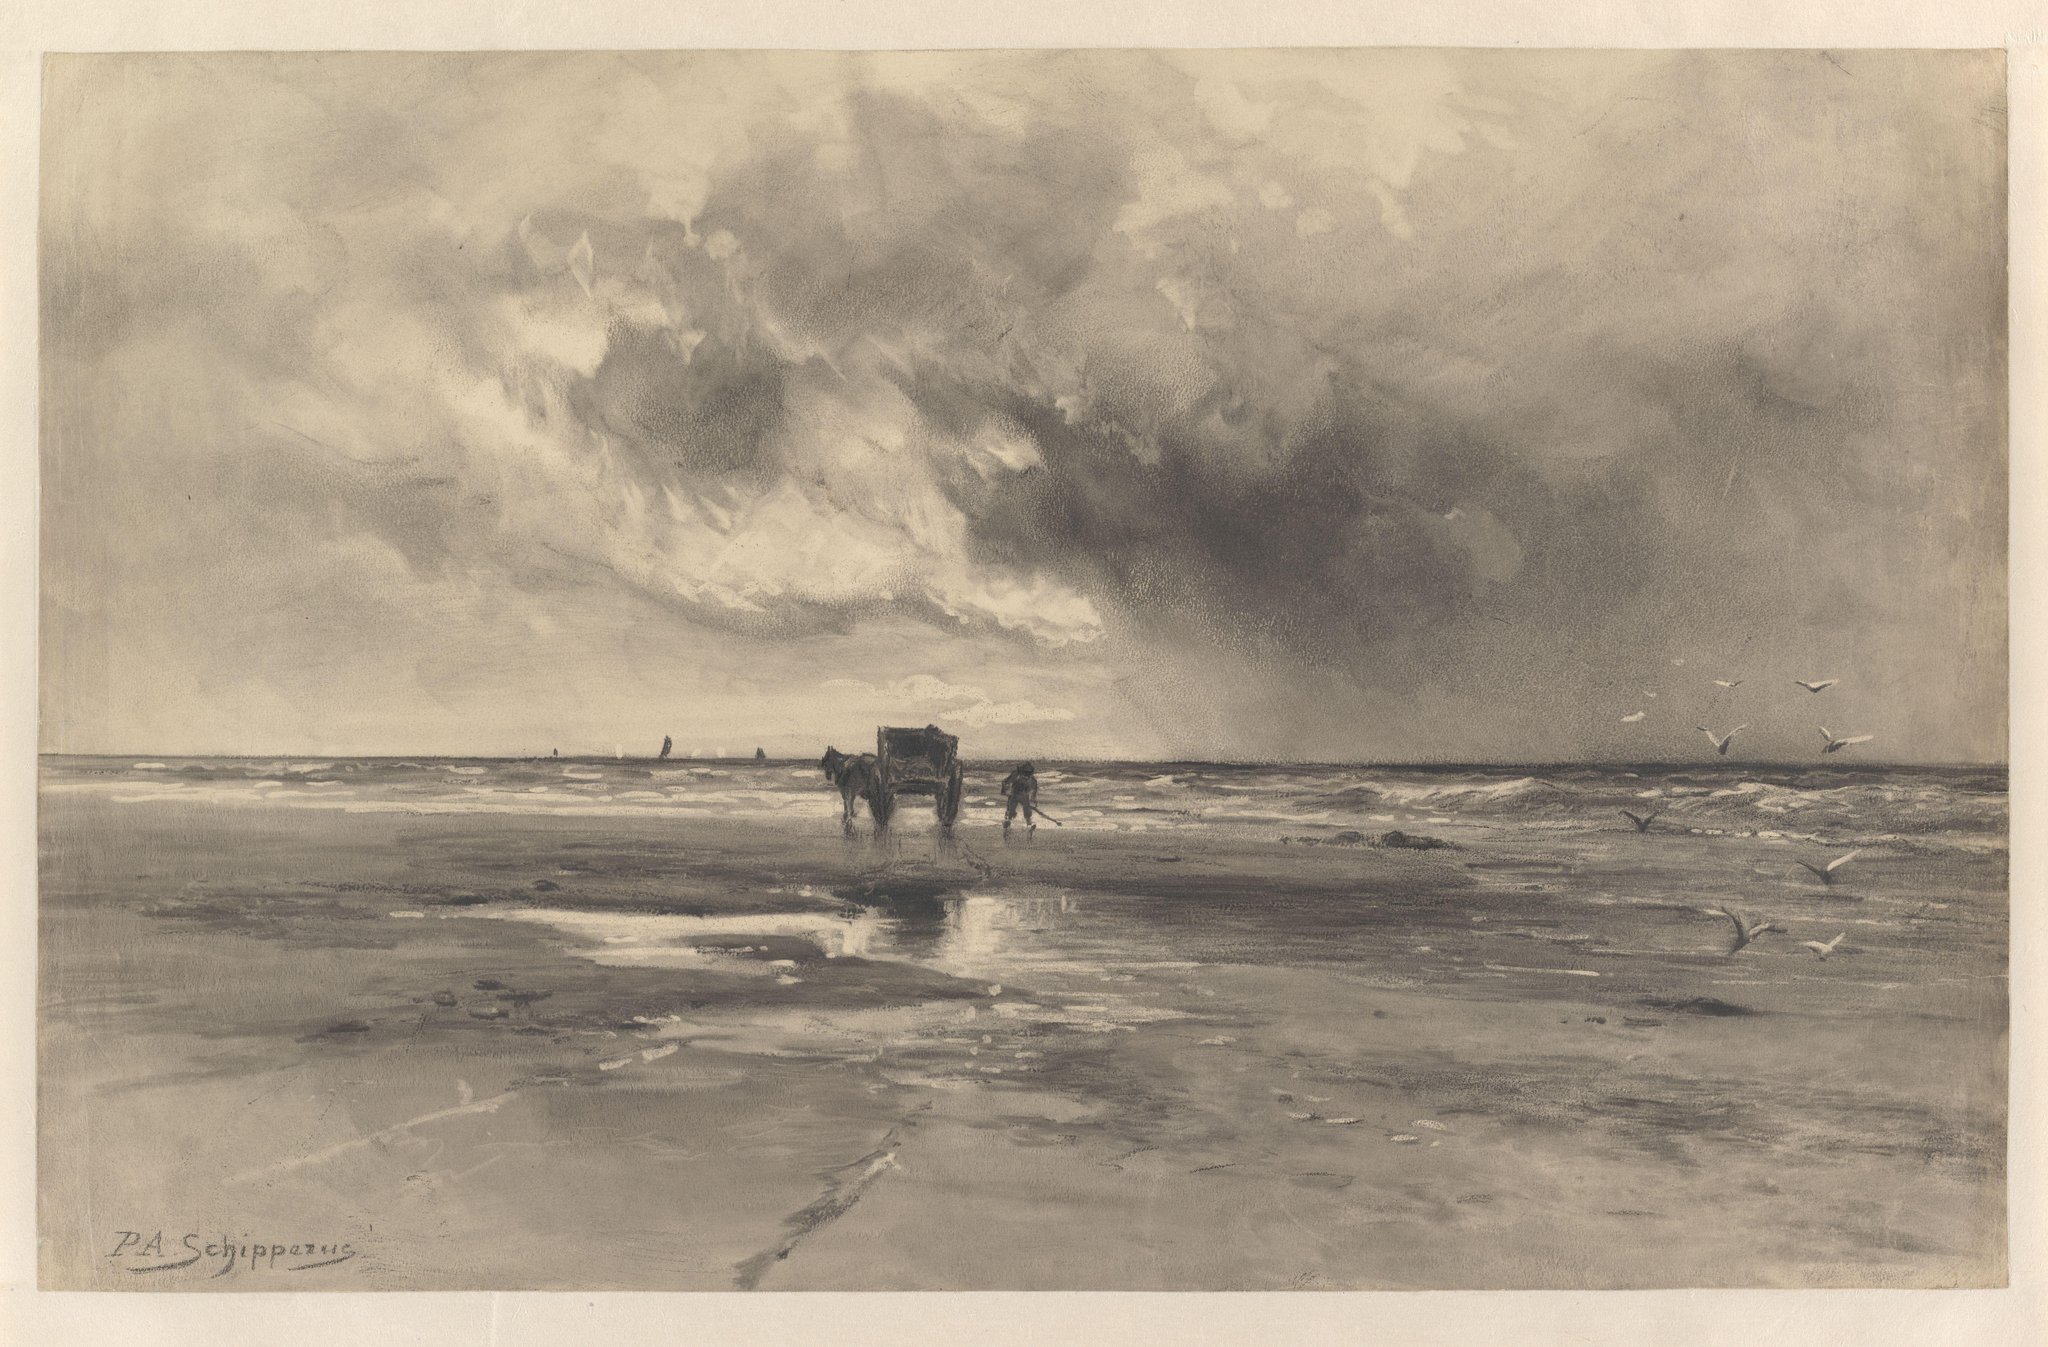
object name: drawing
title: Strand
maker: piet schipperus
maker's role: draughtsman, print maker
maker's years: 1840-1929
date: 1850-1920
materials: chalk, paper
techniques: brush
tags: beach